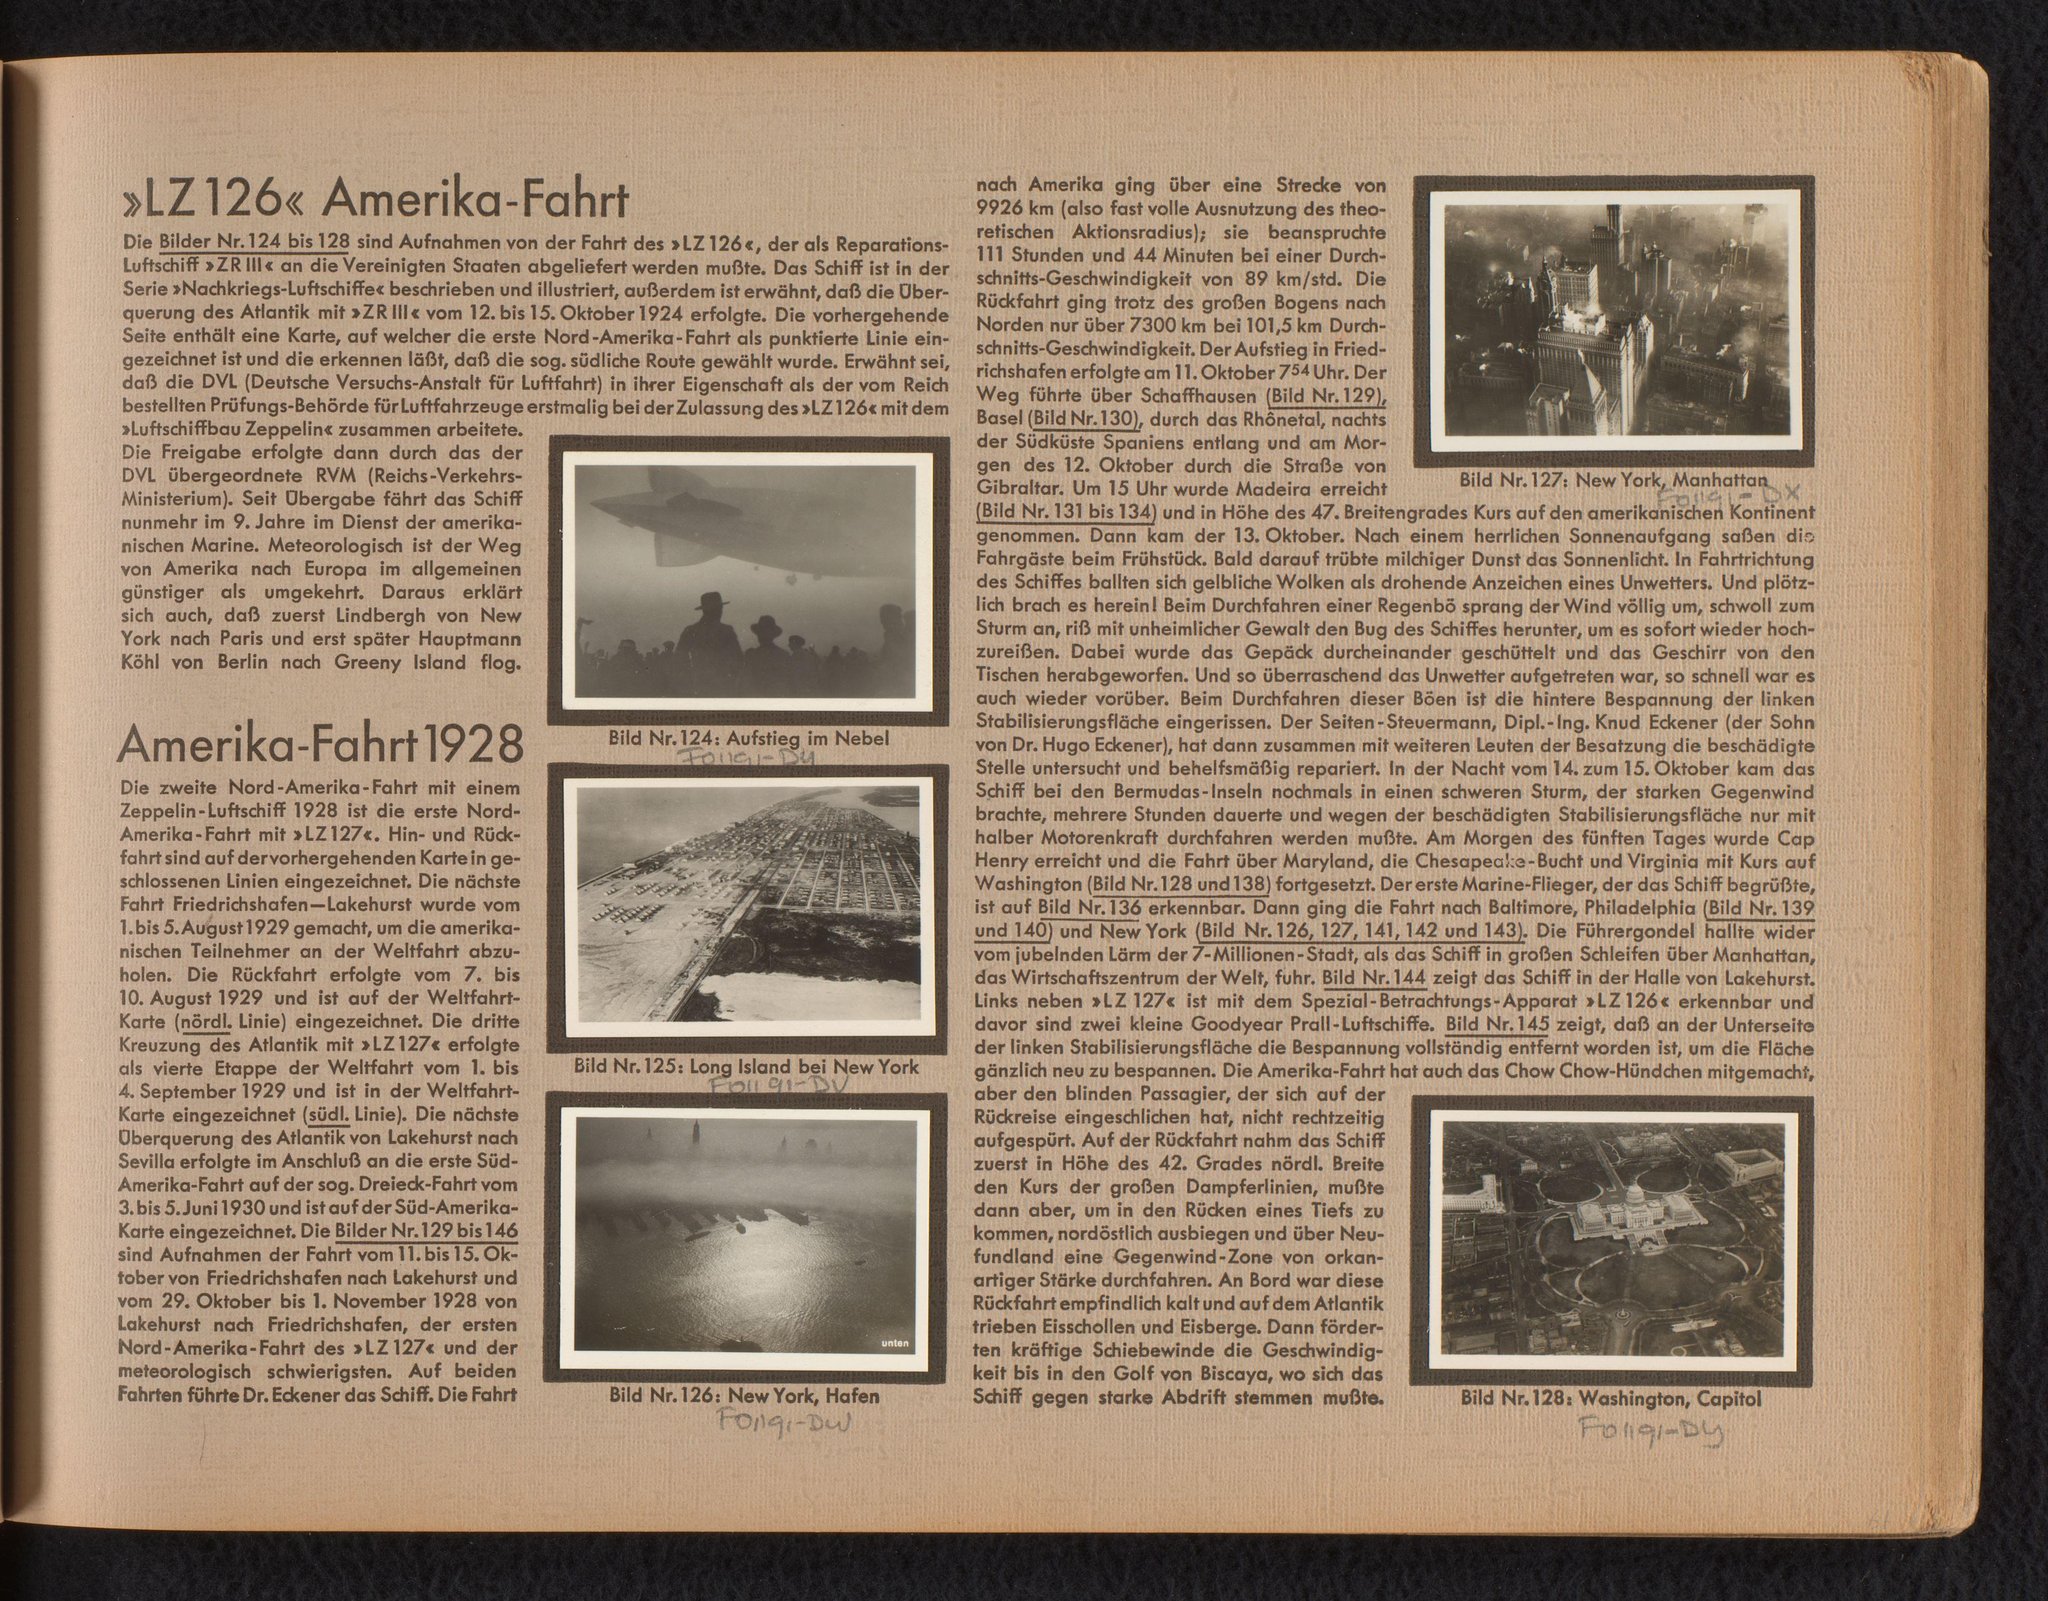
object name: photograph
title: Uitzichten tijdens een vlucht naar de Verenigde Staten van Amerika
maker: Anonymous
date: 1924-1928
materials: paper, photographic support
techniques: gelatin silver print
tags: city-view, and landscape with man-made constructions, island, new york (city)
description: Vijf foto's gemaakt tijdens vluchten naar Verenigde Staten van Amerika, waaronder gezichten op New York en Washington. Alle foto's zijn voorzien van een nummer en titel. Deze pagina maakt deel uit van een album.